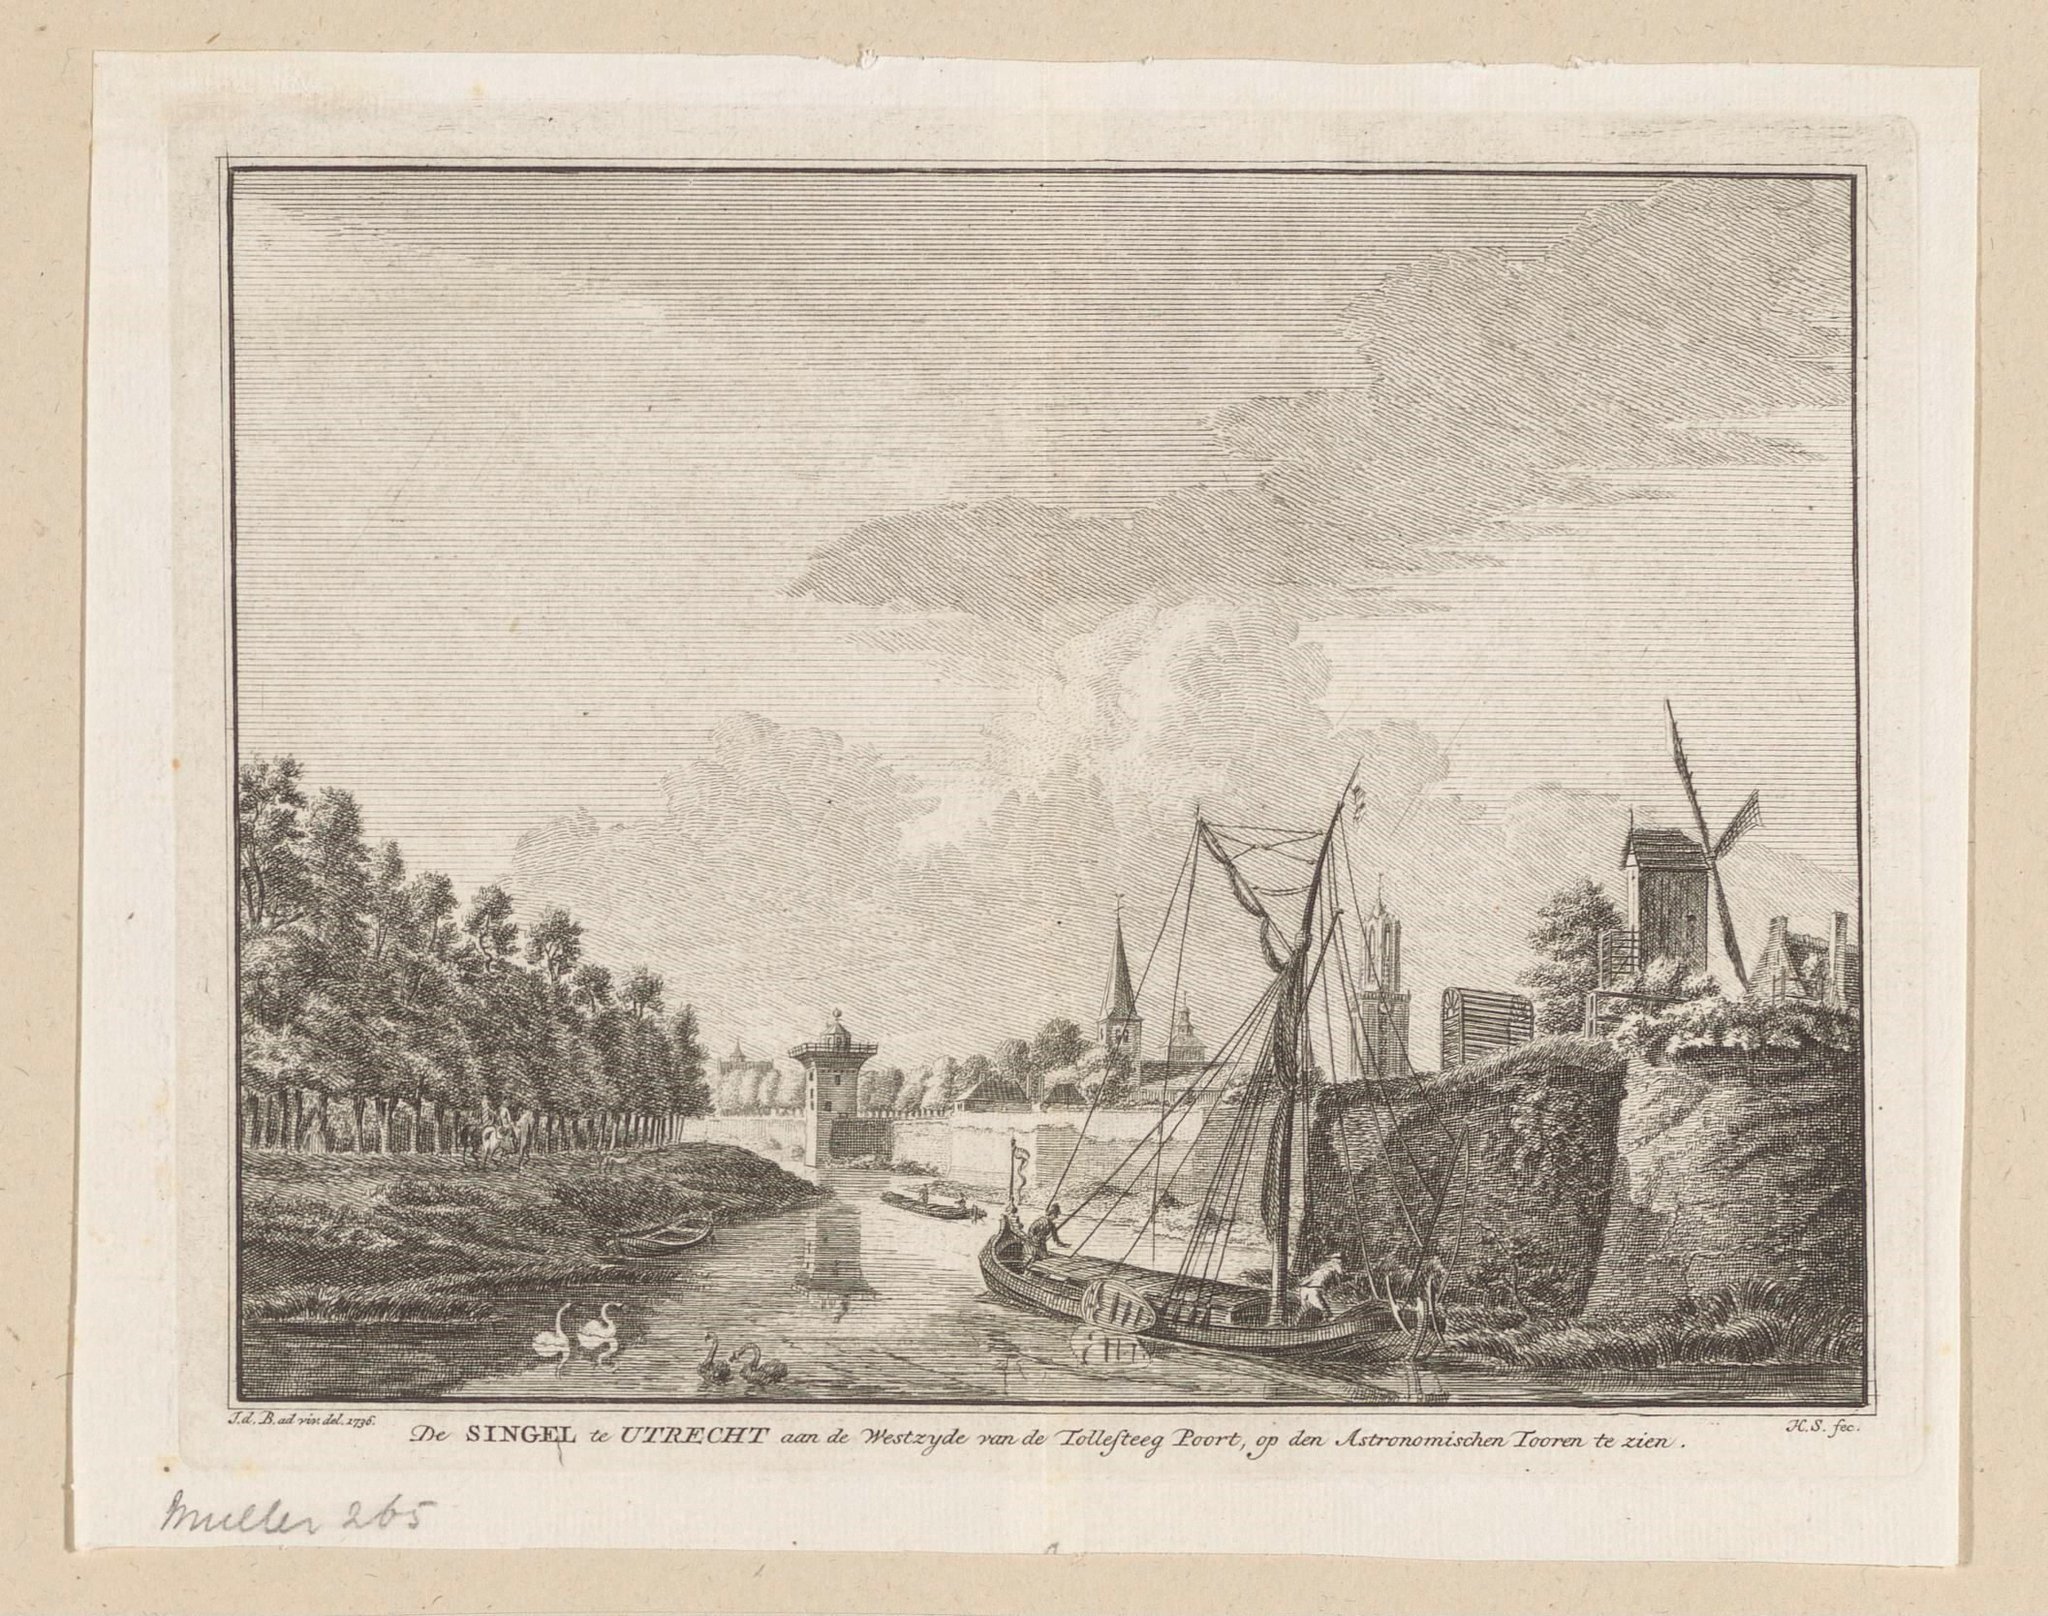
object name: book illustration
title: Gezicht op de stadswal en Smeetoren te Utrecht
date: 1773-1792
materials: paper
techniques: engraving, etching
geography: haarlem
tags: city-walls, bastion, bulwark, windmill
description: Prent ook gebruikt in: Het verheerlykt Nederland of kabinet van hedendaagsche gezigten van steden, dorpen (…) Behelzende honderd gezigten van der Provincie van Utrecht. Amsterdam: weduwe Isaak Tirion, 1773-1774, dl. 7, 8 of 9, niet genummerd, te vinden na ill. 144 en voor ill. 201. Of in: Nederlandsche tafereelen; of eene keurige verzameling van negen honderd fraaije gezigten van steden, dorpen, sloten, oudheden (….). 9 delen. Amsterdam: Jan de Groot, 1792, dl. 7, 8 of 9, niet genummerd, te vinden na ill. 144 en voor ill. 201. Uit welke druk het huidige exemplaar precies komt is niet na te gaan.